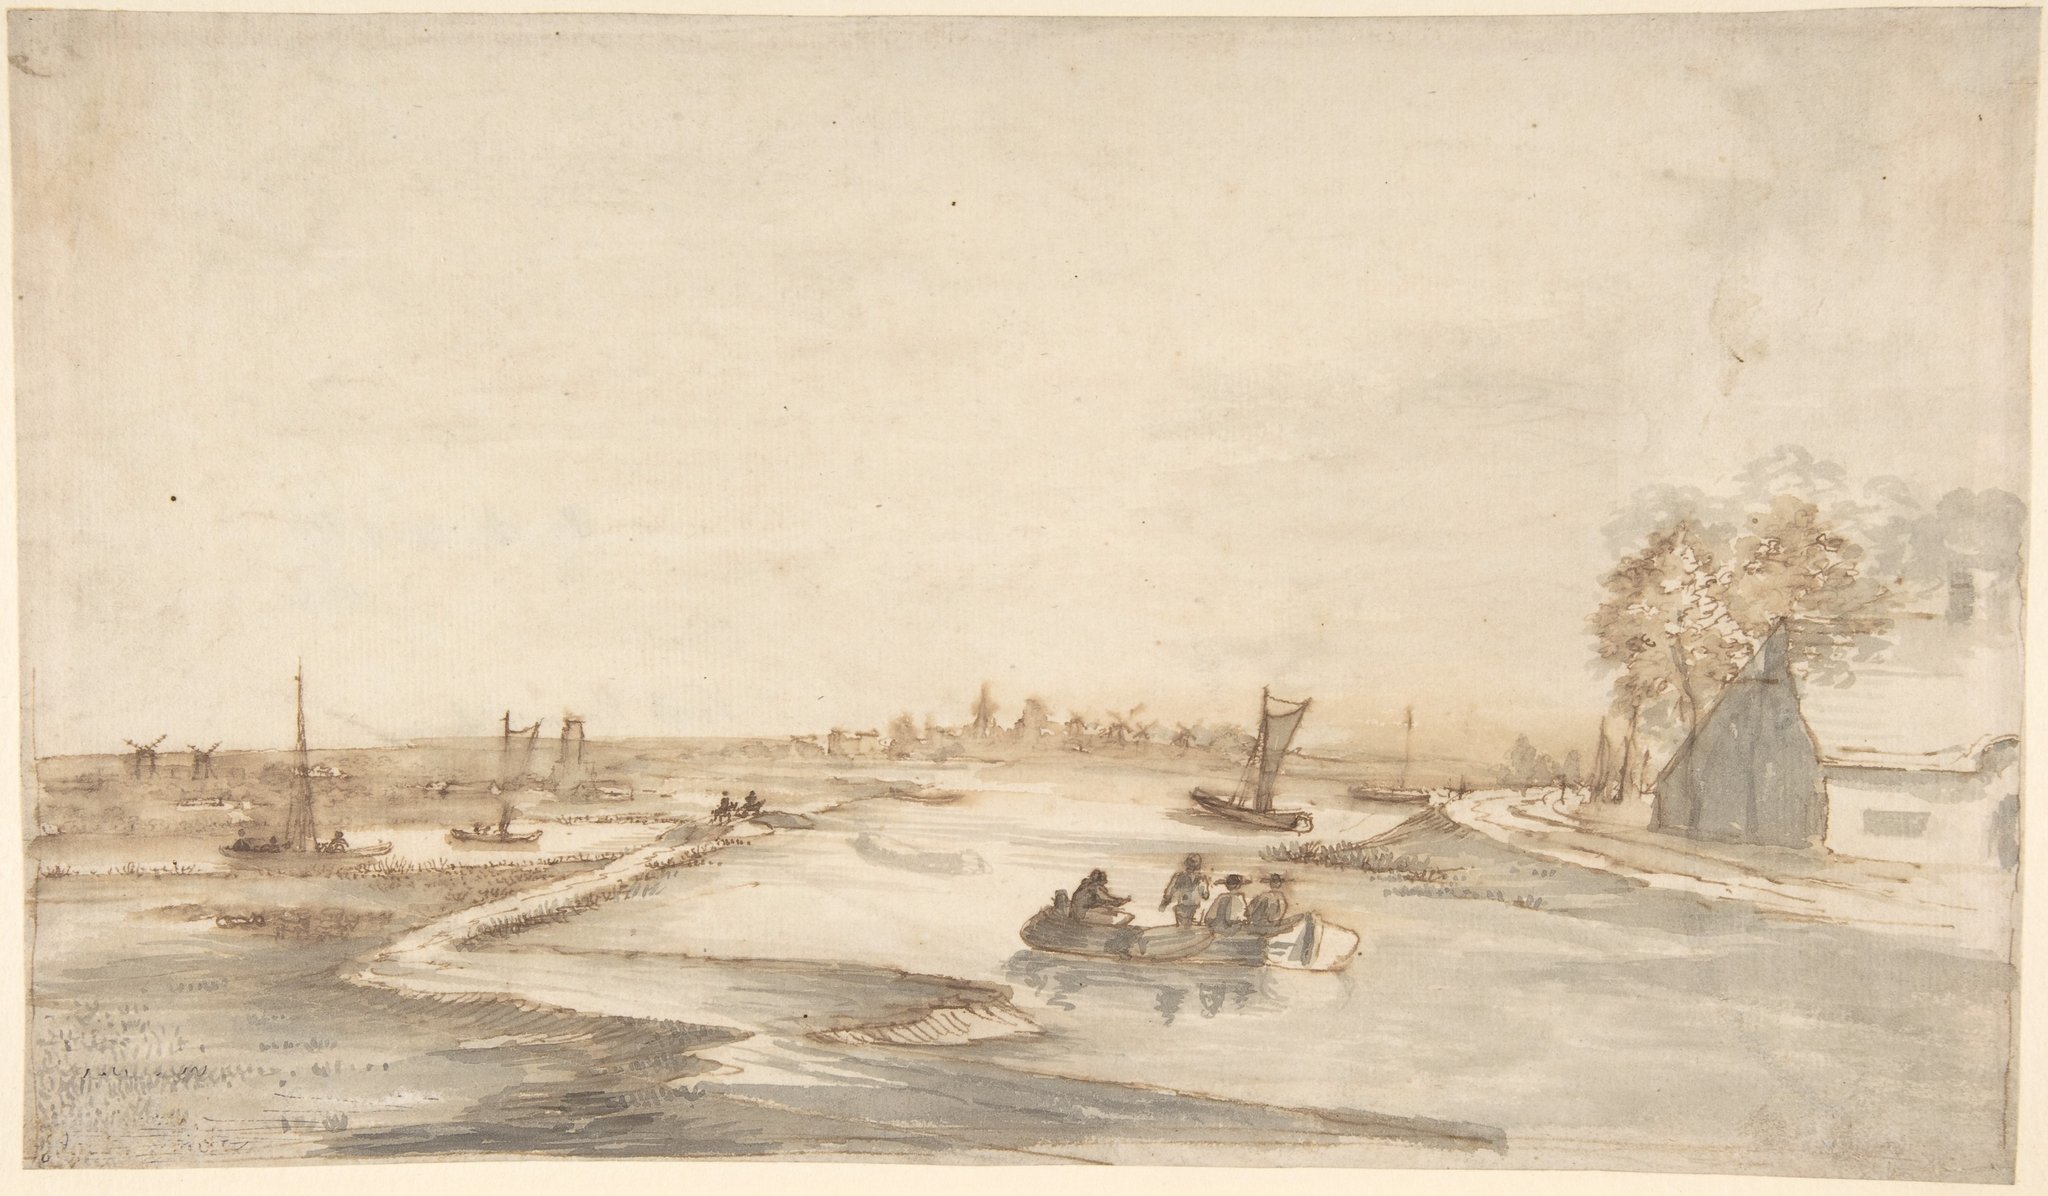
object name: drawing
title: Canal Landscape with Figures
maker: abraham de verwer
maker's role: artist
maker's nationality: dutch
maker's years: 1600-1650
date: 1601-1700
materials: ink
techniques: pen, wash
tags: houses,landscapes,boats